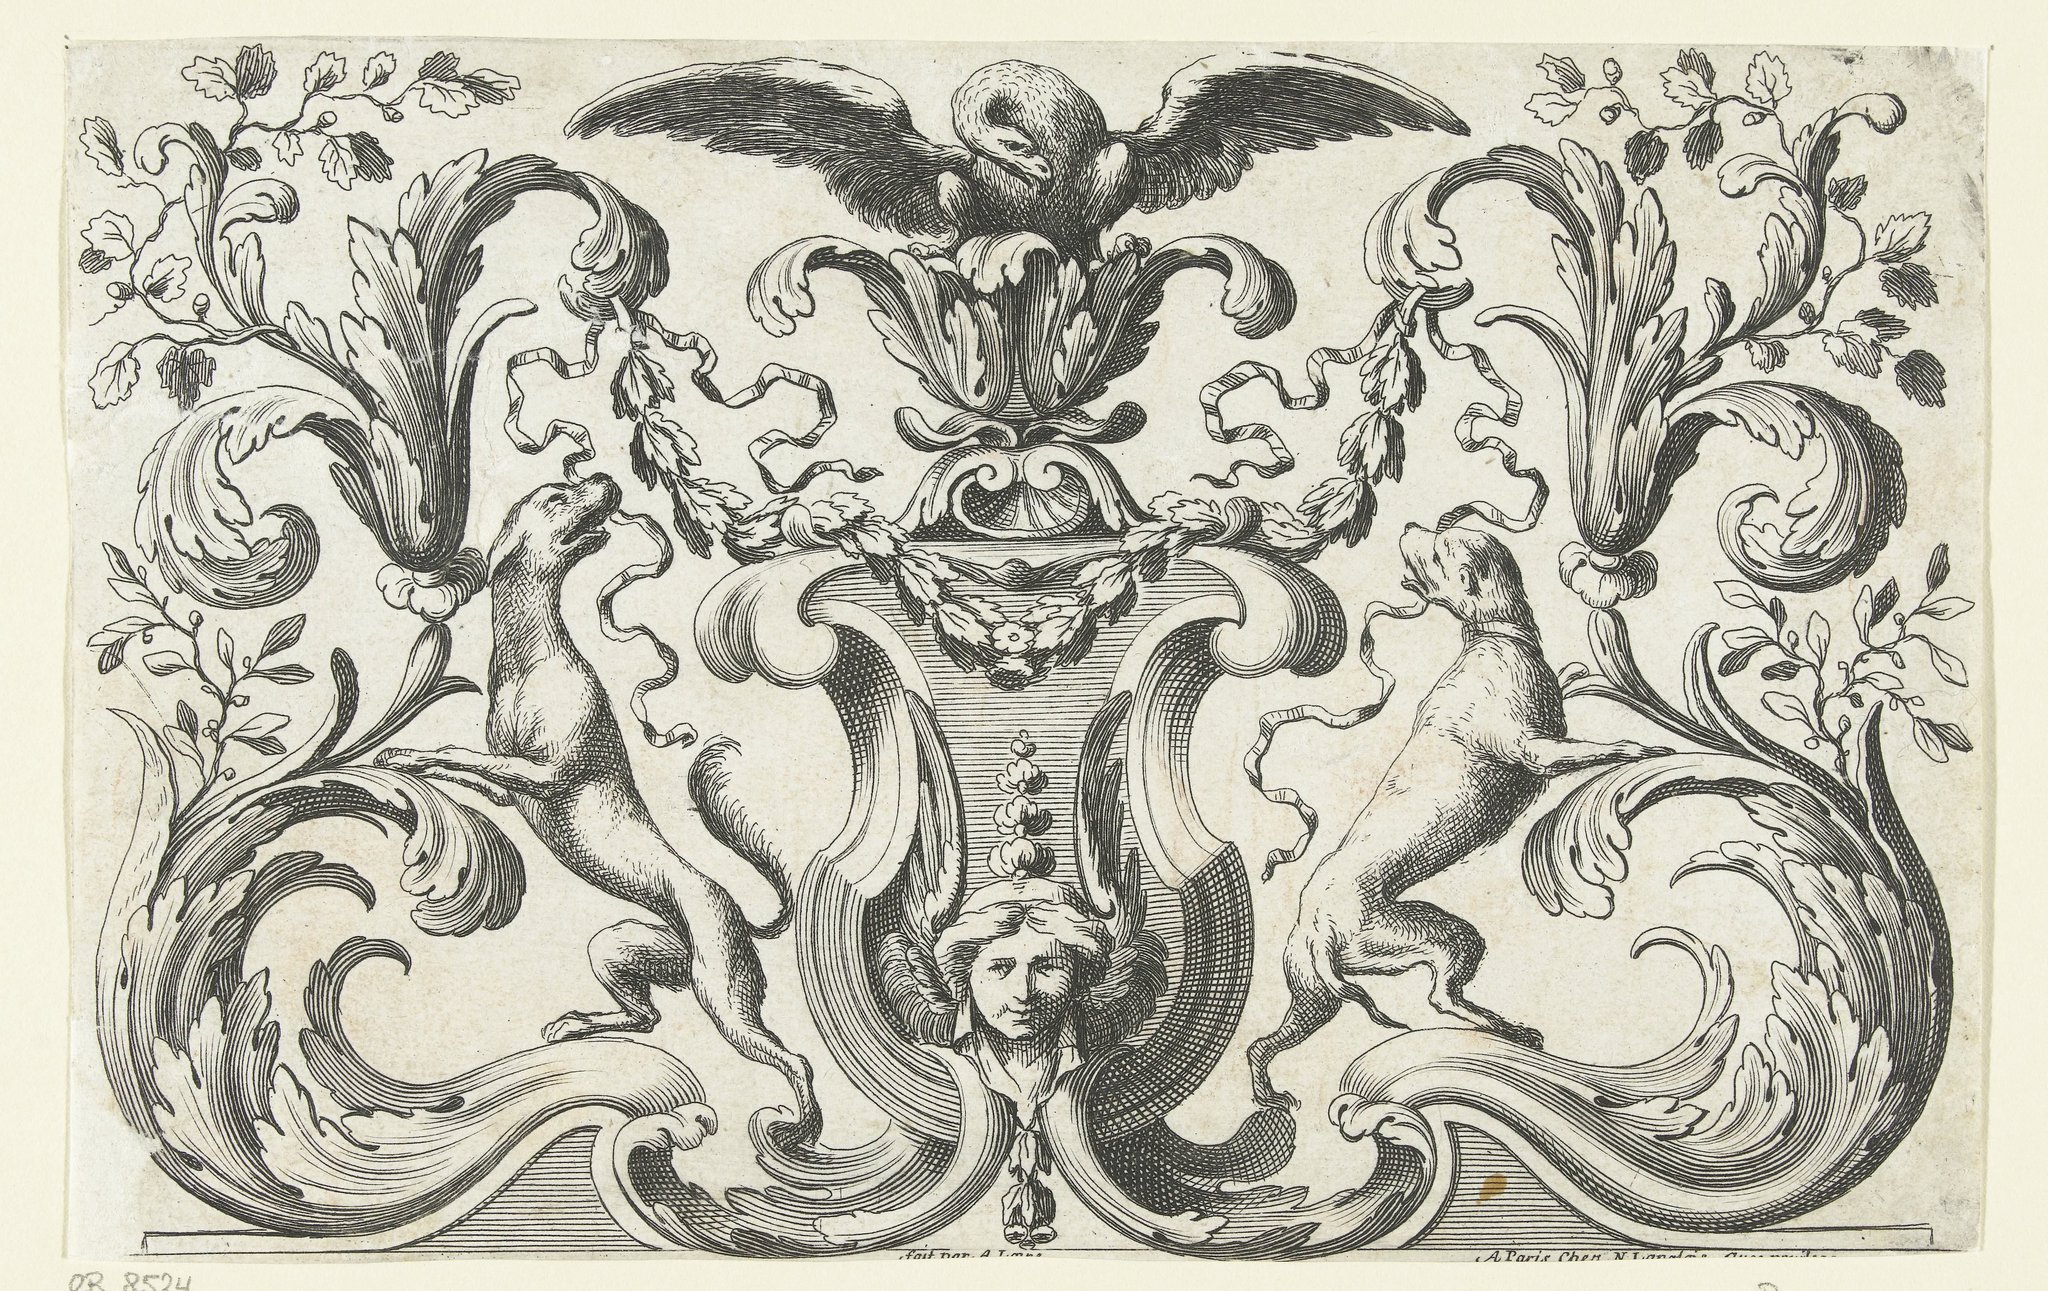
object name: ornament print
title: Paneel met voetstuk tussen twee honden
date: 1670-1690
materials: paper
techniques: etching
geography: france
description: Op het voetstuk zit een adelaar. Uit serie van 6 bladen met friezen en ornamentele panelen.